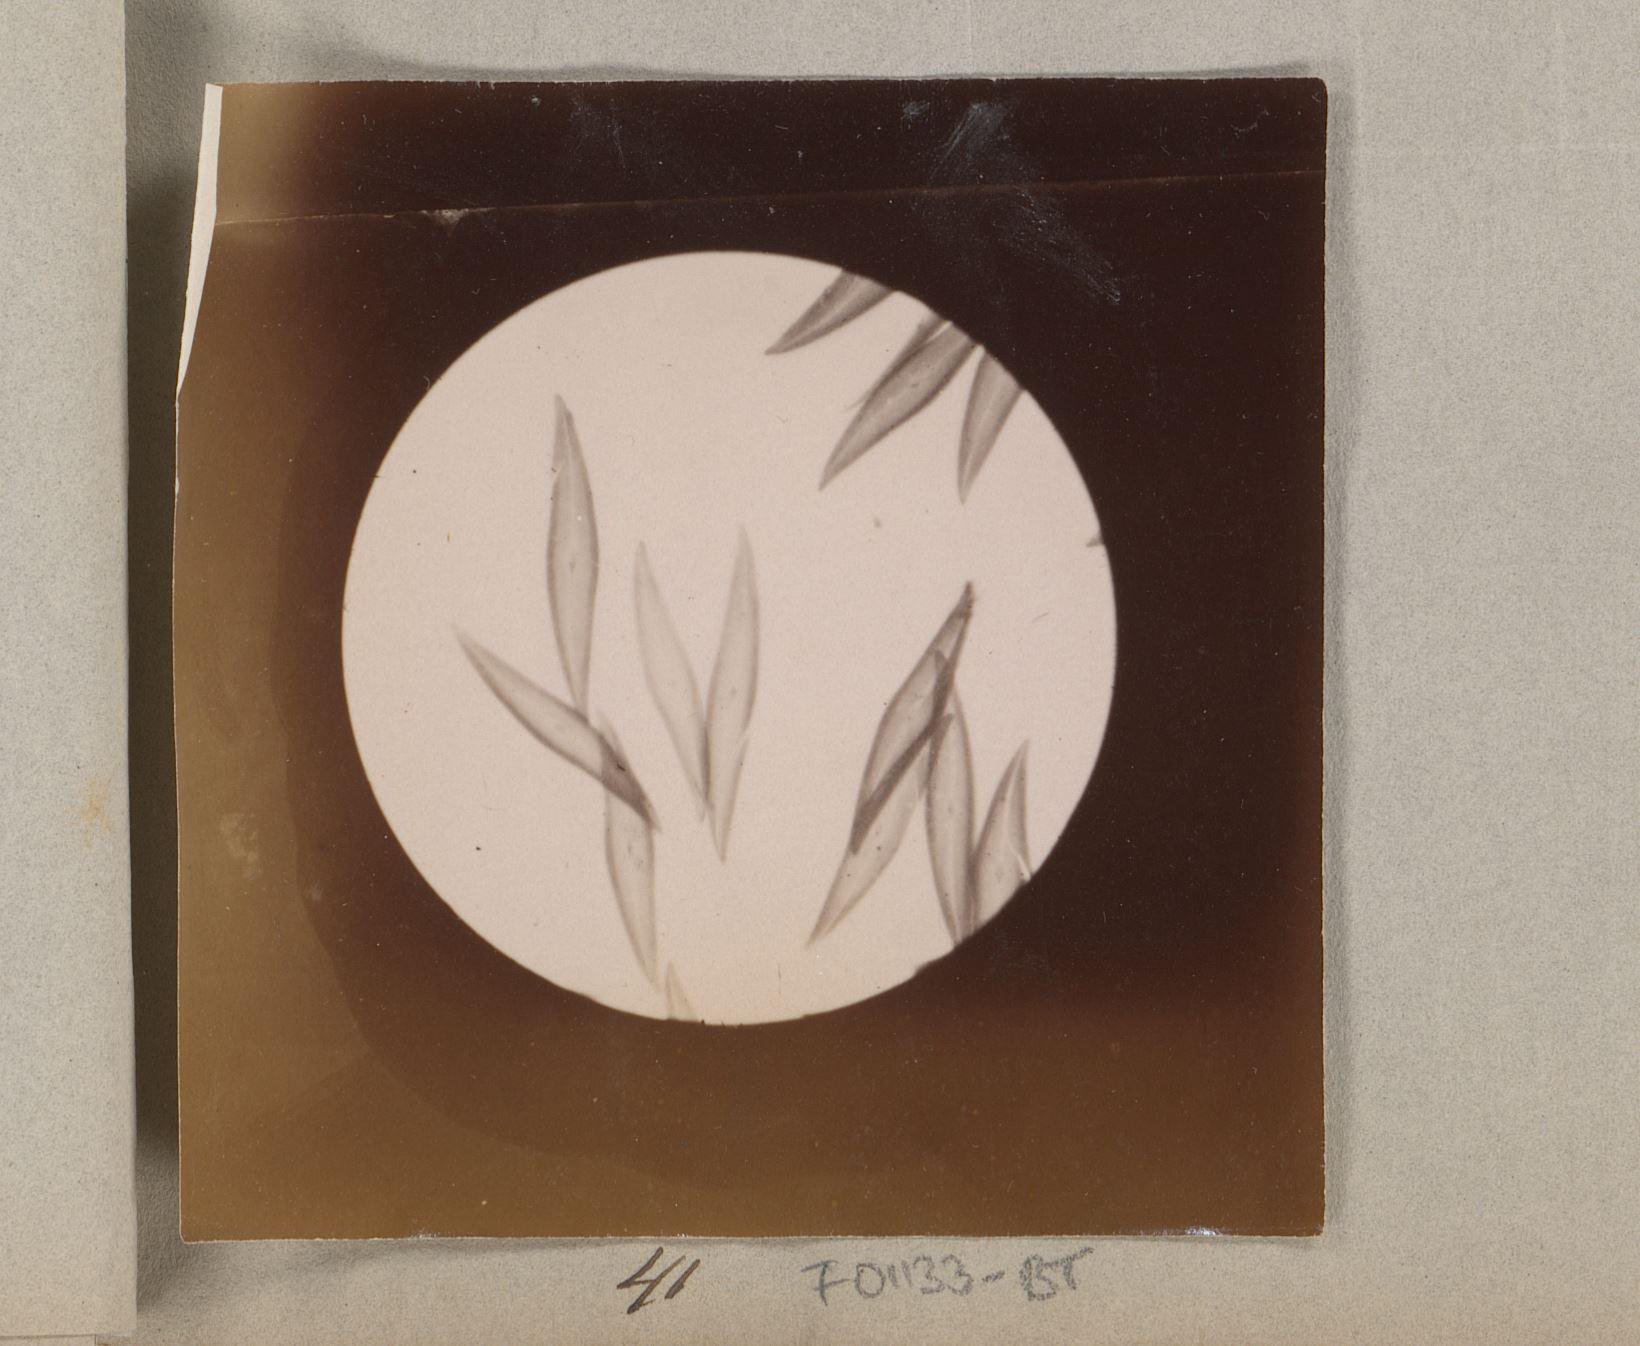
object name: album leaf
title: Microscopische opname van diatomeeën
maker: marinus pieter filbri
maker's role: instrument maker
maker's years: 1852-1917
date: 1887-1888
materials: paper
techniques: albumen print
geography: netherlands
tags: algae, seaweed, netherlands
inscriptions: inscription: ‘No. 41. Benaming Diatomeen Pleur.Aug., vergroting (?), pose -, bemerking -’, number: ‘41’